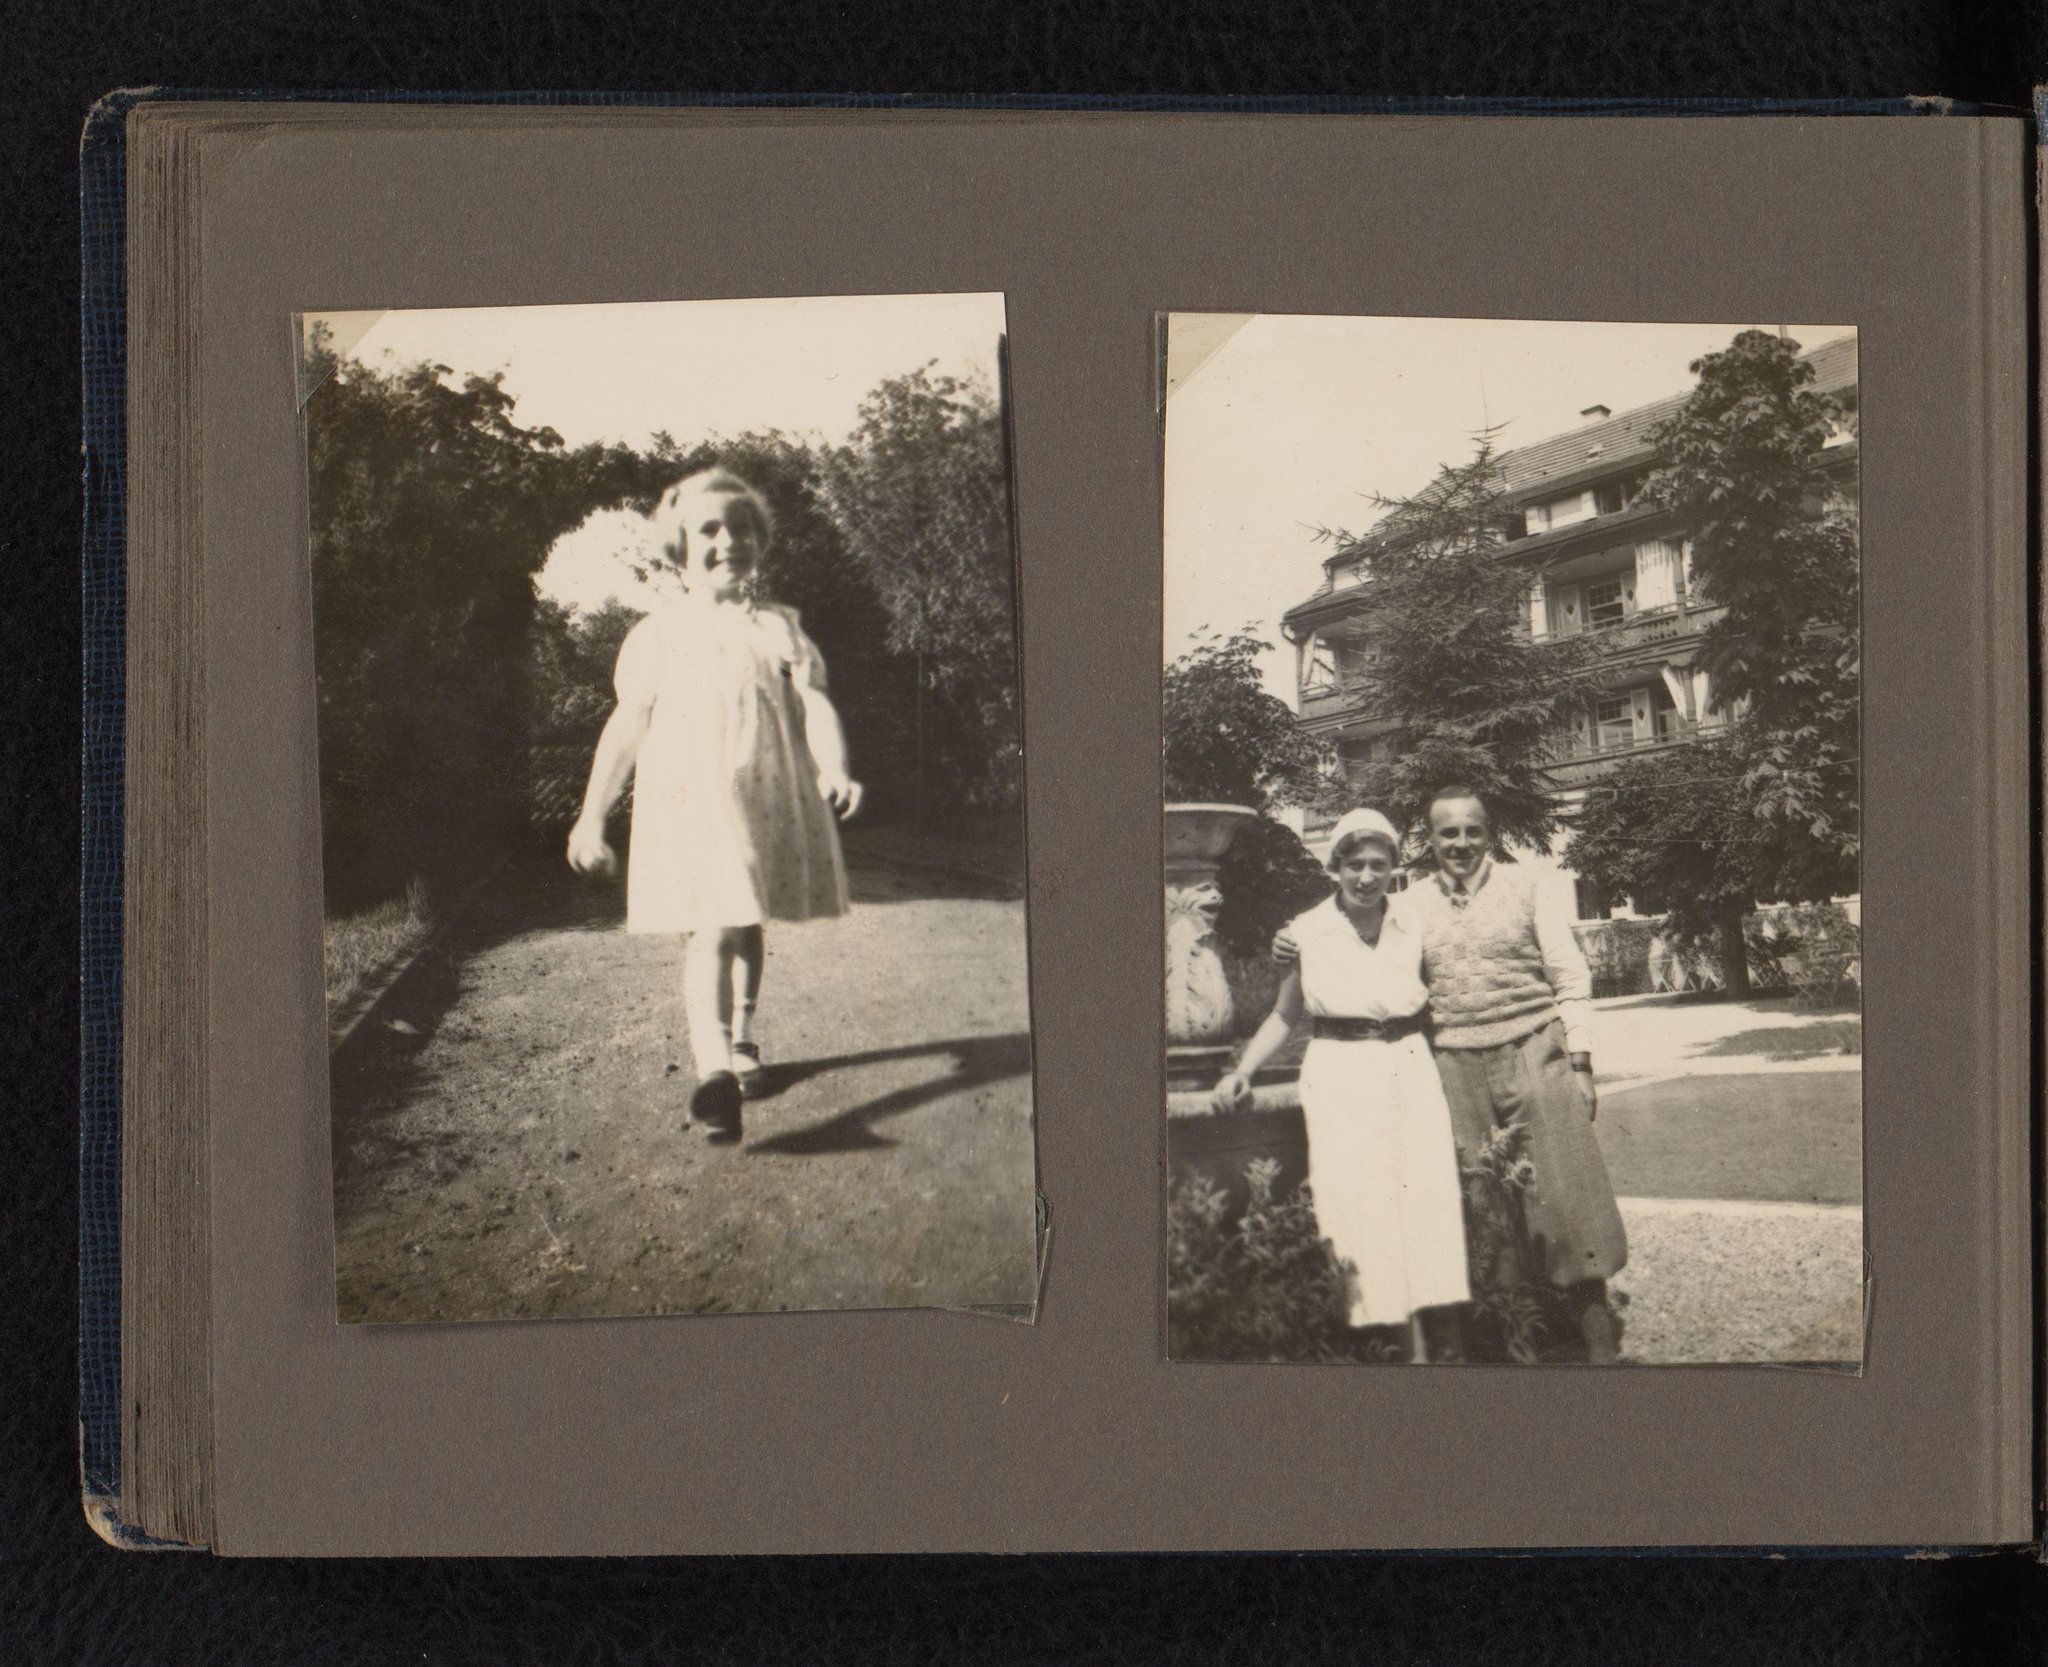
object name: album leaf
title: Onbekend kind en onbekende man en vrouw, vermoedelijk na 1932, vermoedelijk in Duitsland of Oostenrijk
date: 1932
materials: paper, photographic support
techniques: gelatin silver print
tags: germany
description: Albumblad bevat twee foto's van onbekende vrouw en man met onbekend kind. Uit album half formaat, blauw kunstlederen omslag met koordbinding.